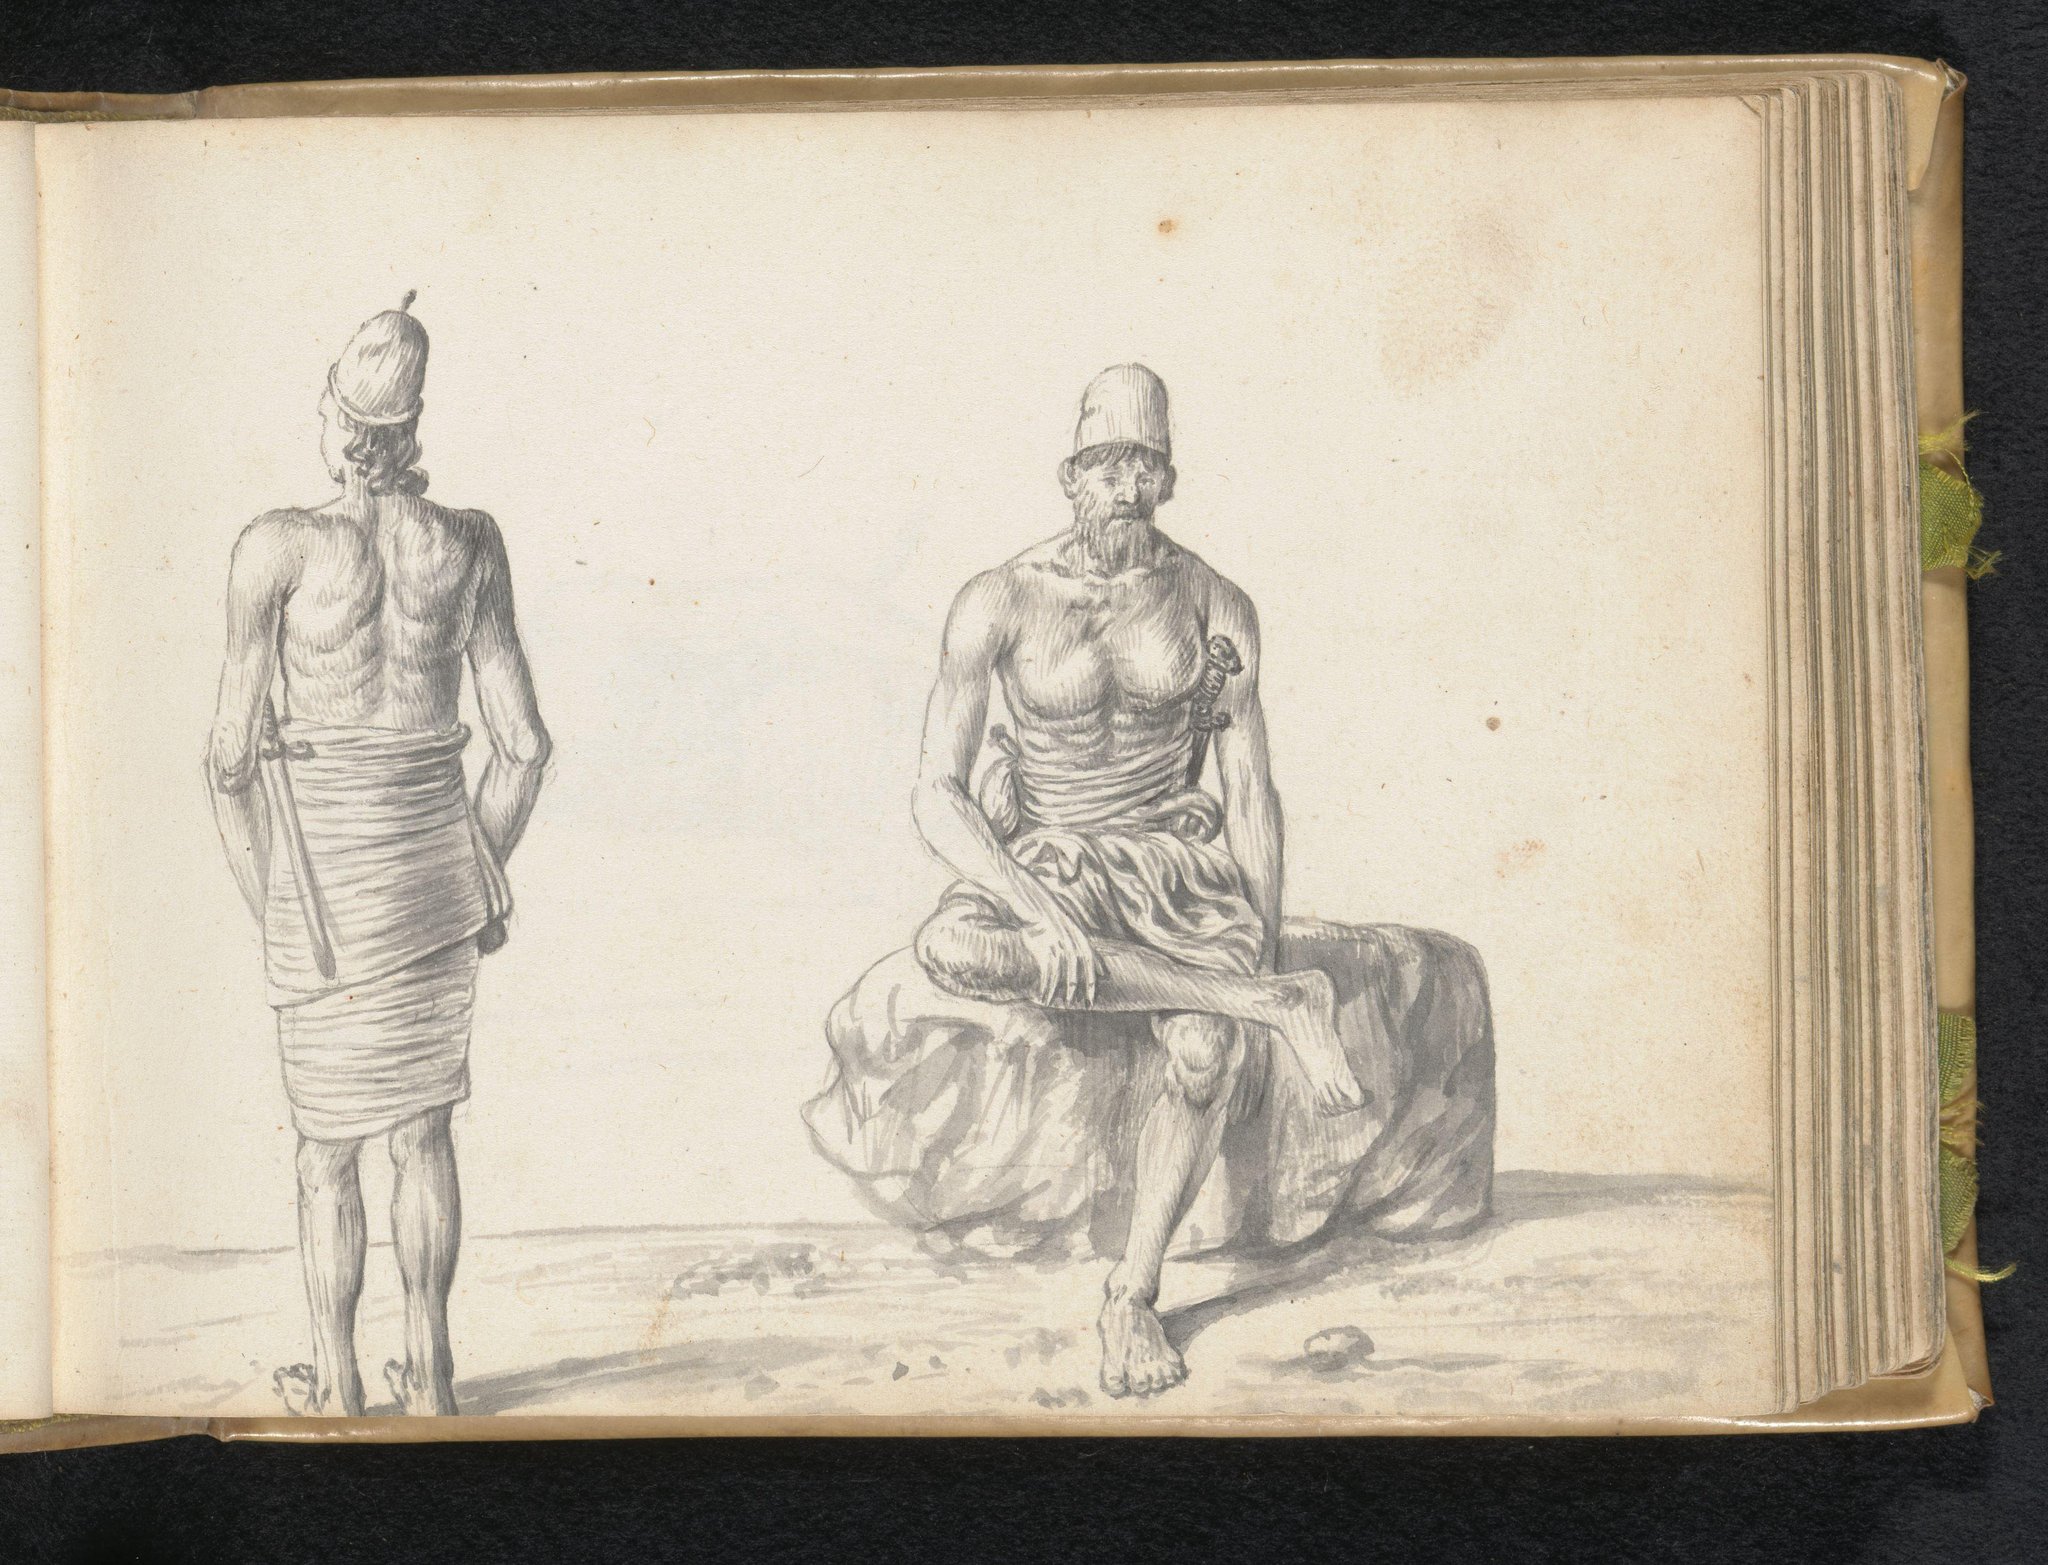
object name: sketchbook leaf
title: Two Sinhalese soldiers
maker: esaias boursse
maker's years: 1631-1672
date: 1662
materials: ink, paper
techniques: brush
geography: sri lanka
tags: asiatic races and peoples (srilankans), asiatic races and peoples (with name), skirt (dhoti), 41d232(...) skirt (lungi), hacing and thrusting weapons (with name), the soldier; the soldier's life, sri lanka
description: Twee mannen buiten op een oneffen terrein. De man links draagt een knielang heupkleed (veshti, lungi) in de taille dubbelgevouwen. Op zijn linkerheup hangt een kort zwaard (kastane). Onder de hoge ronde muts hangt lang golvend haar in zijn nek. De man rechts, zittend op een steen met het rechterbeen gevouwen op de linkerknie. Hij draagt een tot boven de knie opgeschort heupkleed (veshti, lungi); daarboven is een brede tailleband gewikkeld waarvan de uiteinden los hangen. Op de linkerheup is het versierde gevest te zien van een kort zwaard (kastane). Onder de rechterarm steekt boven de tailleband het handvat uit van waarschijnlijk een mes. De man heeft een baard en een snor, en op zijn voorhoofd steekt kort haar uit onder de hoge ronde muts. Beide mannen zijn Singalese huursoldaten (lascorijnen) nu in dienst van de Nederlanders. Ze horen tot de kaste der Goviiya. Blad 4 uit een schetsboek met 117 bladen.